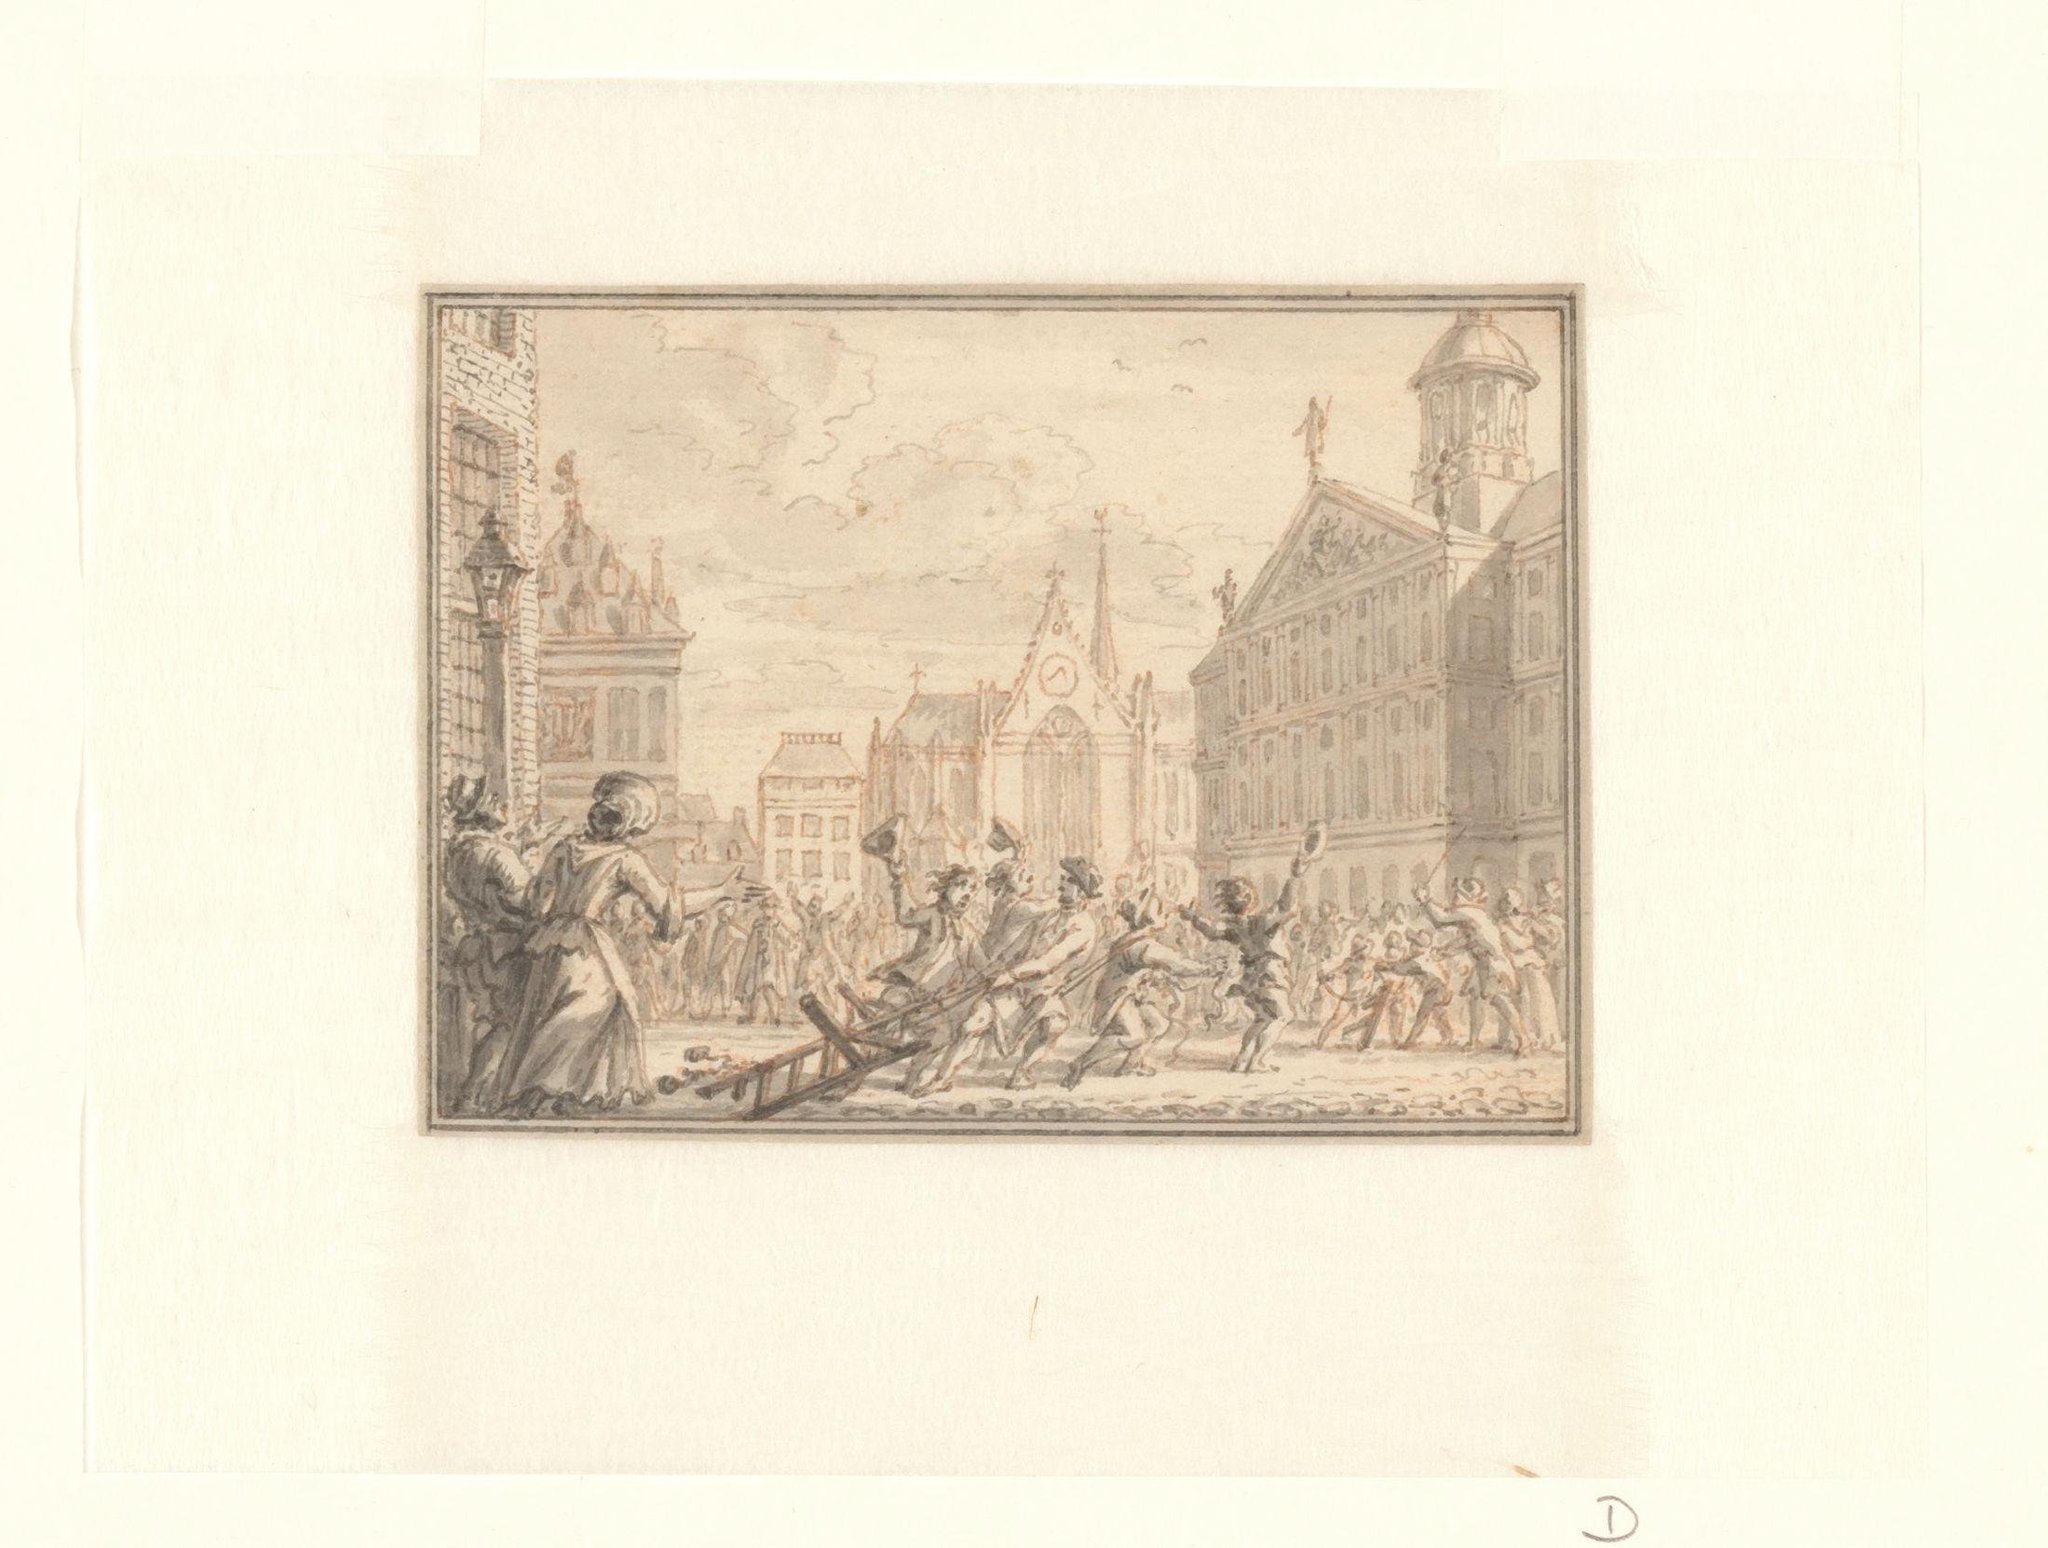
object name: drawing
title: Tumult op de Dam bij de begrafenis van Daniël Raap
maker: simon fokke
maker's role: draughtsman, print maker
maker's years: 1712-1784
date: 1754-1784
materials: ink, paper, pencil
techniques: brush, pen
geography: amsterdam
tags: crowd, mob, city-view in general; 'veduta', funerary ceremonial, street-fights, riots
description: Ontwerptekening voor prent door Cornelis Brouwer, gebruikt in: Arend Fokke Simonsz. De vaderlandsche historie in themata. Amsterdam: Arend Fokke Simonsz., edities tussen 1783-ca. 1792.